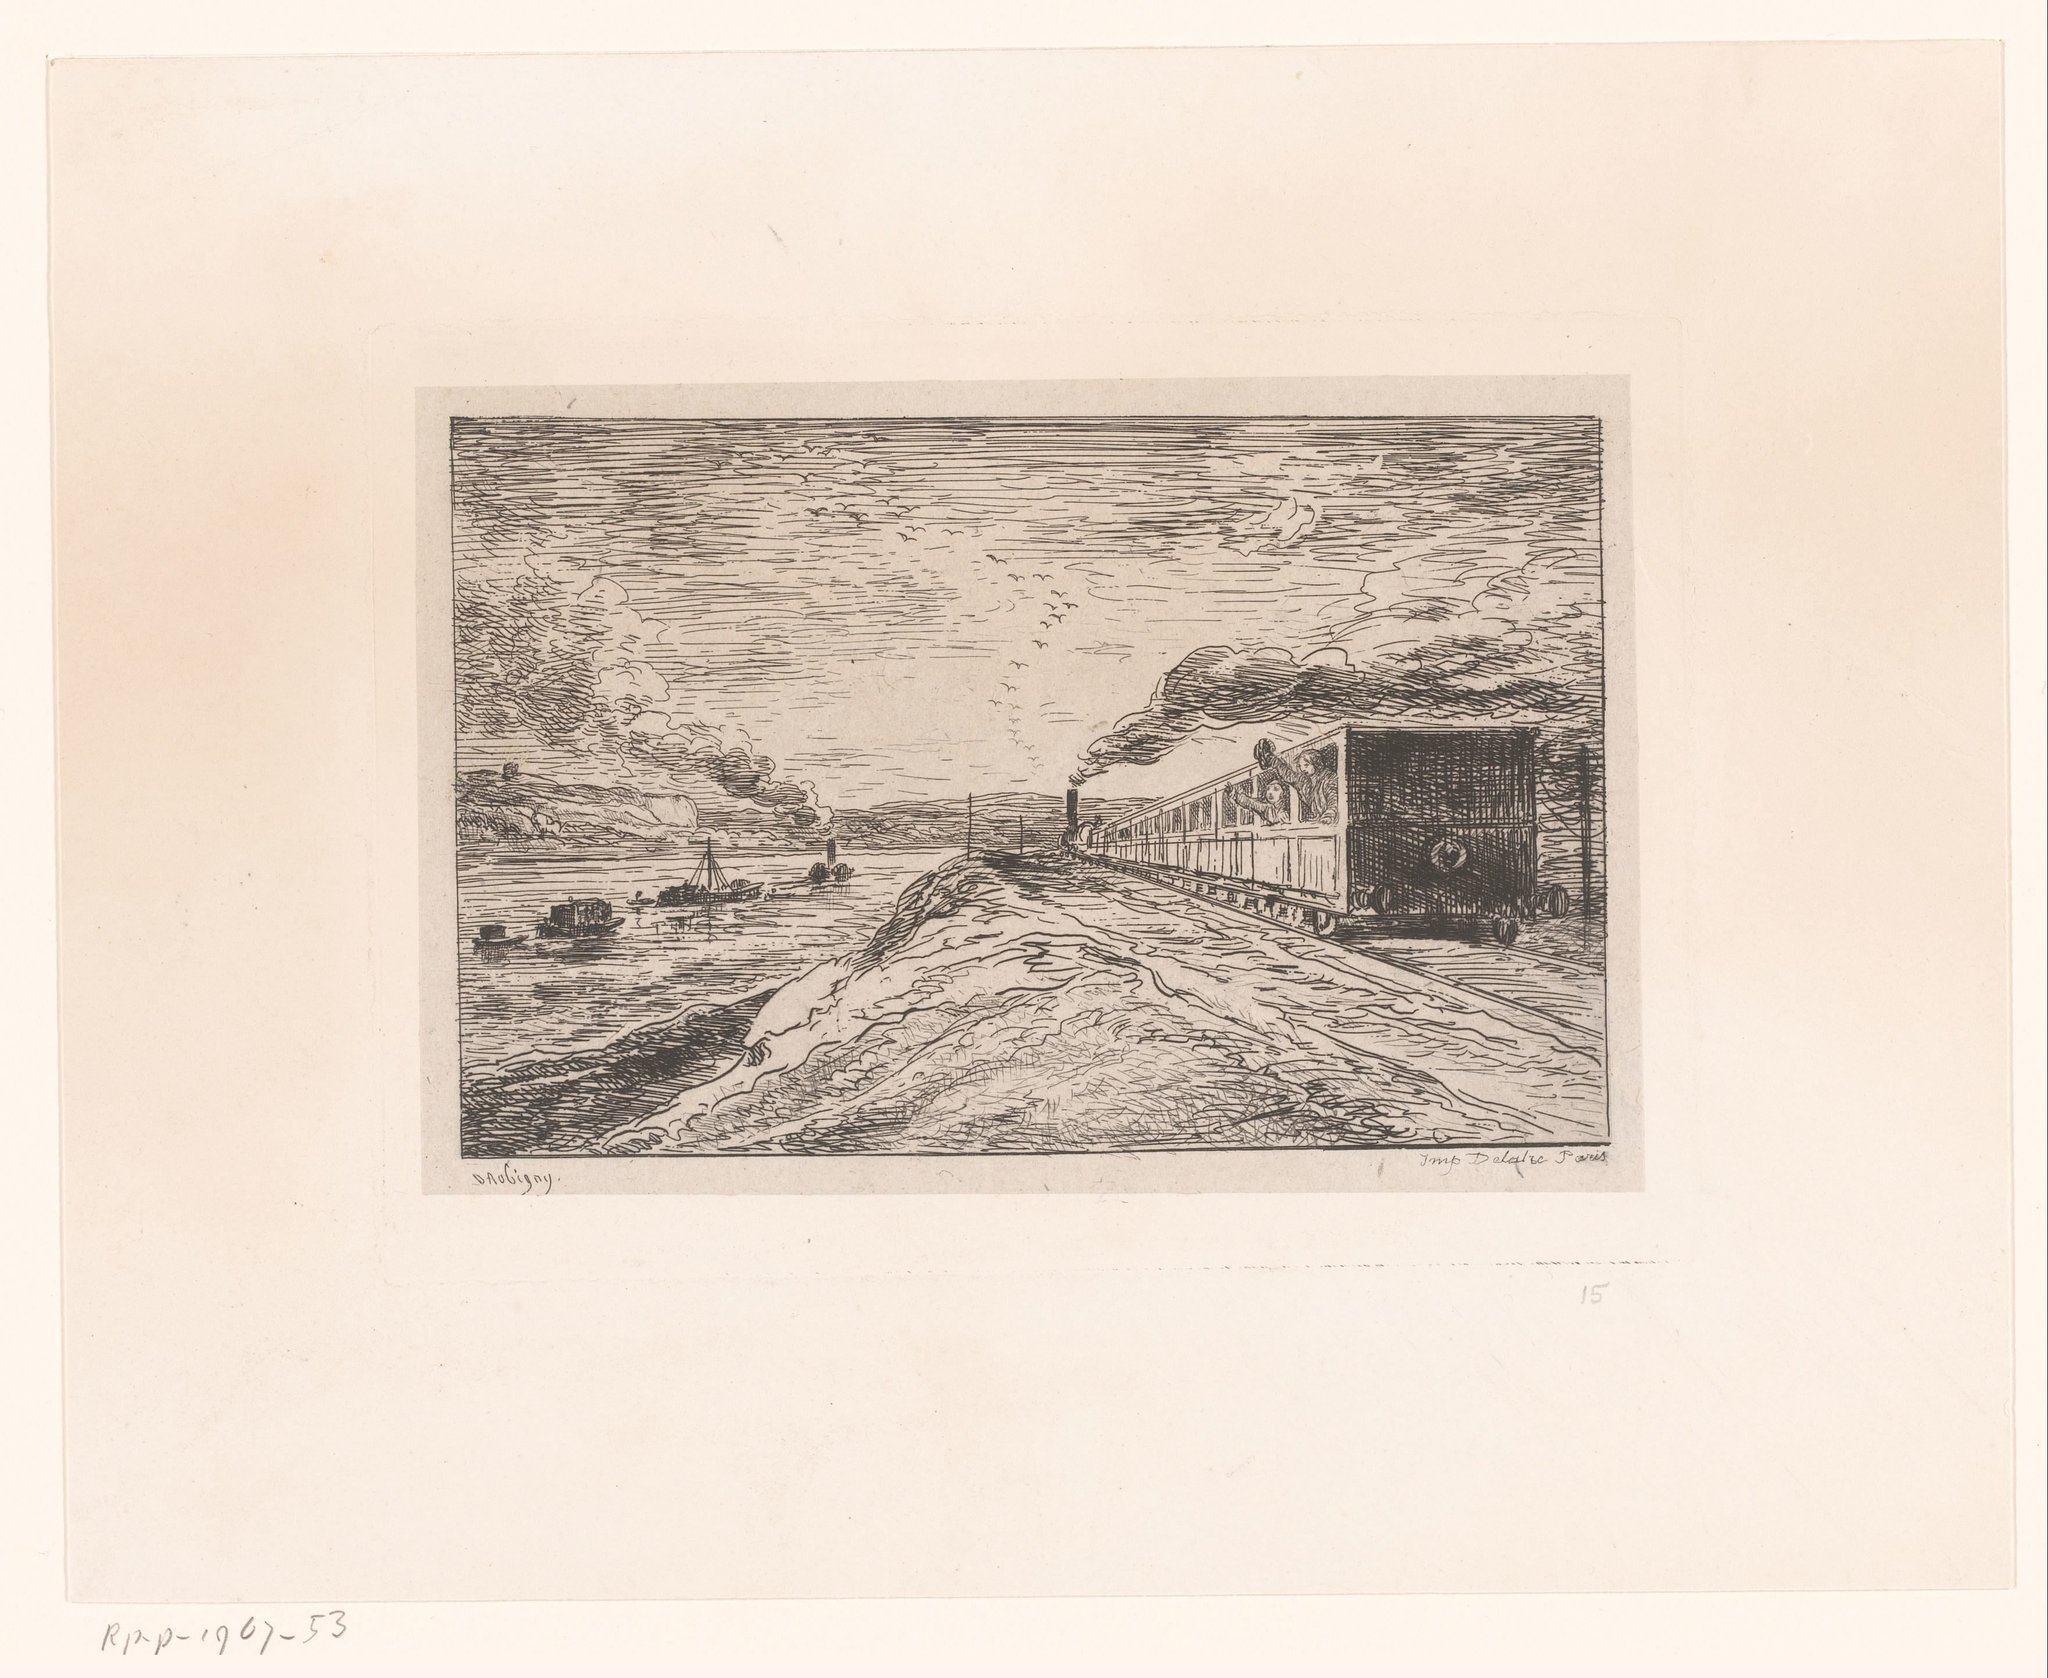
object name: print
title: Le départ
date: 1867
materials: paper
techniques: drypoint, engraving, etching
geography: paris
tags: landscapes, river, railway, train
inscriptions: collector's mark: Lugt 2760, collector's mark: Lugt 2228